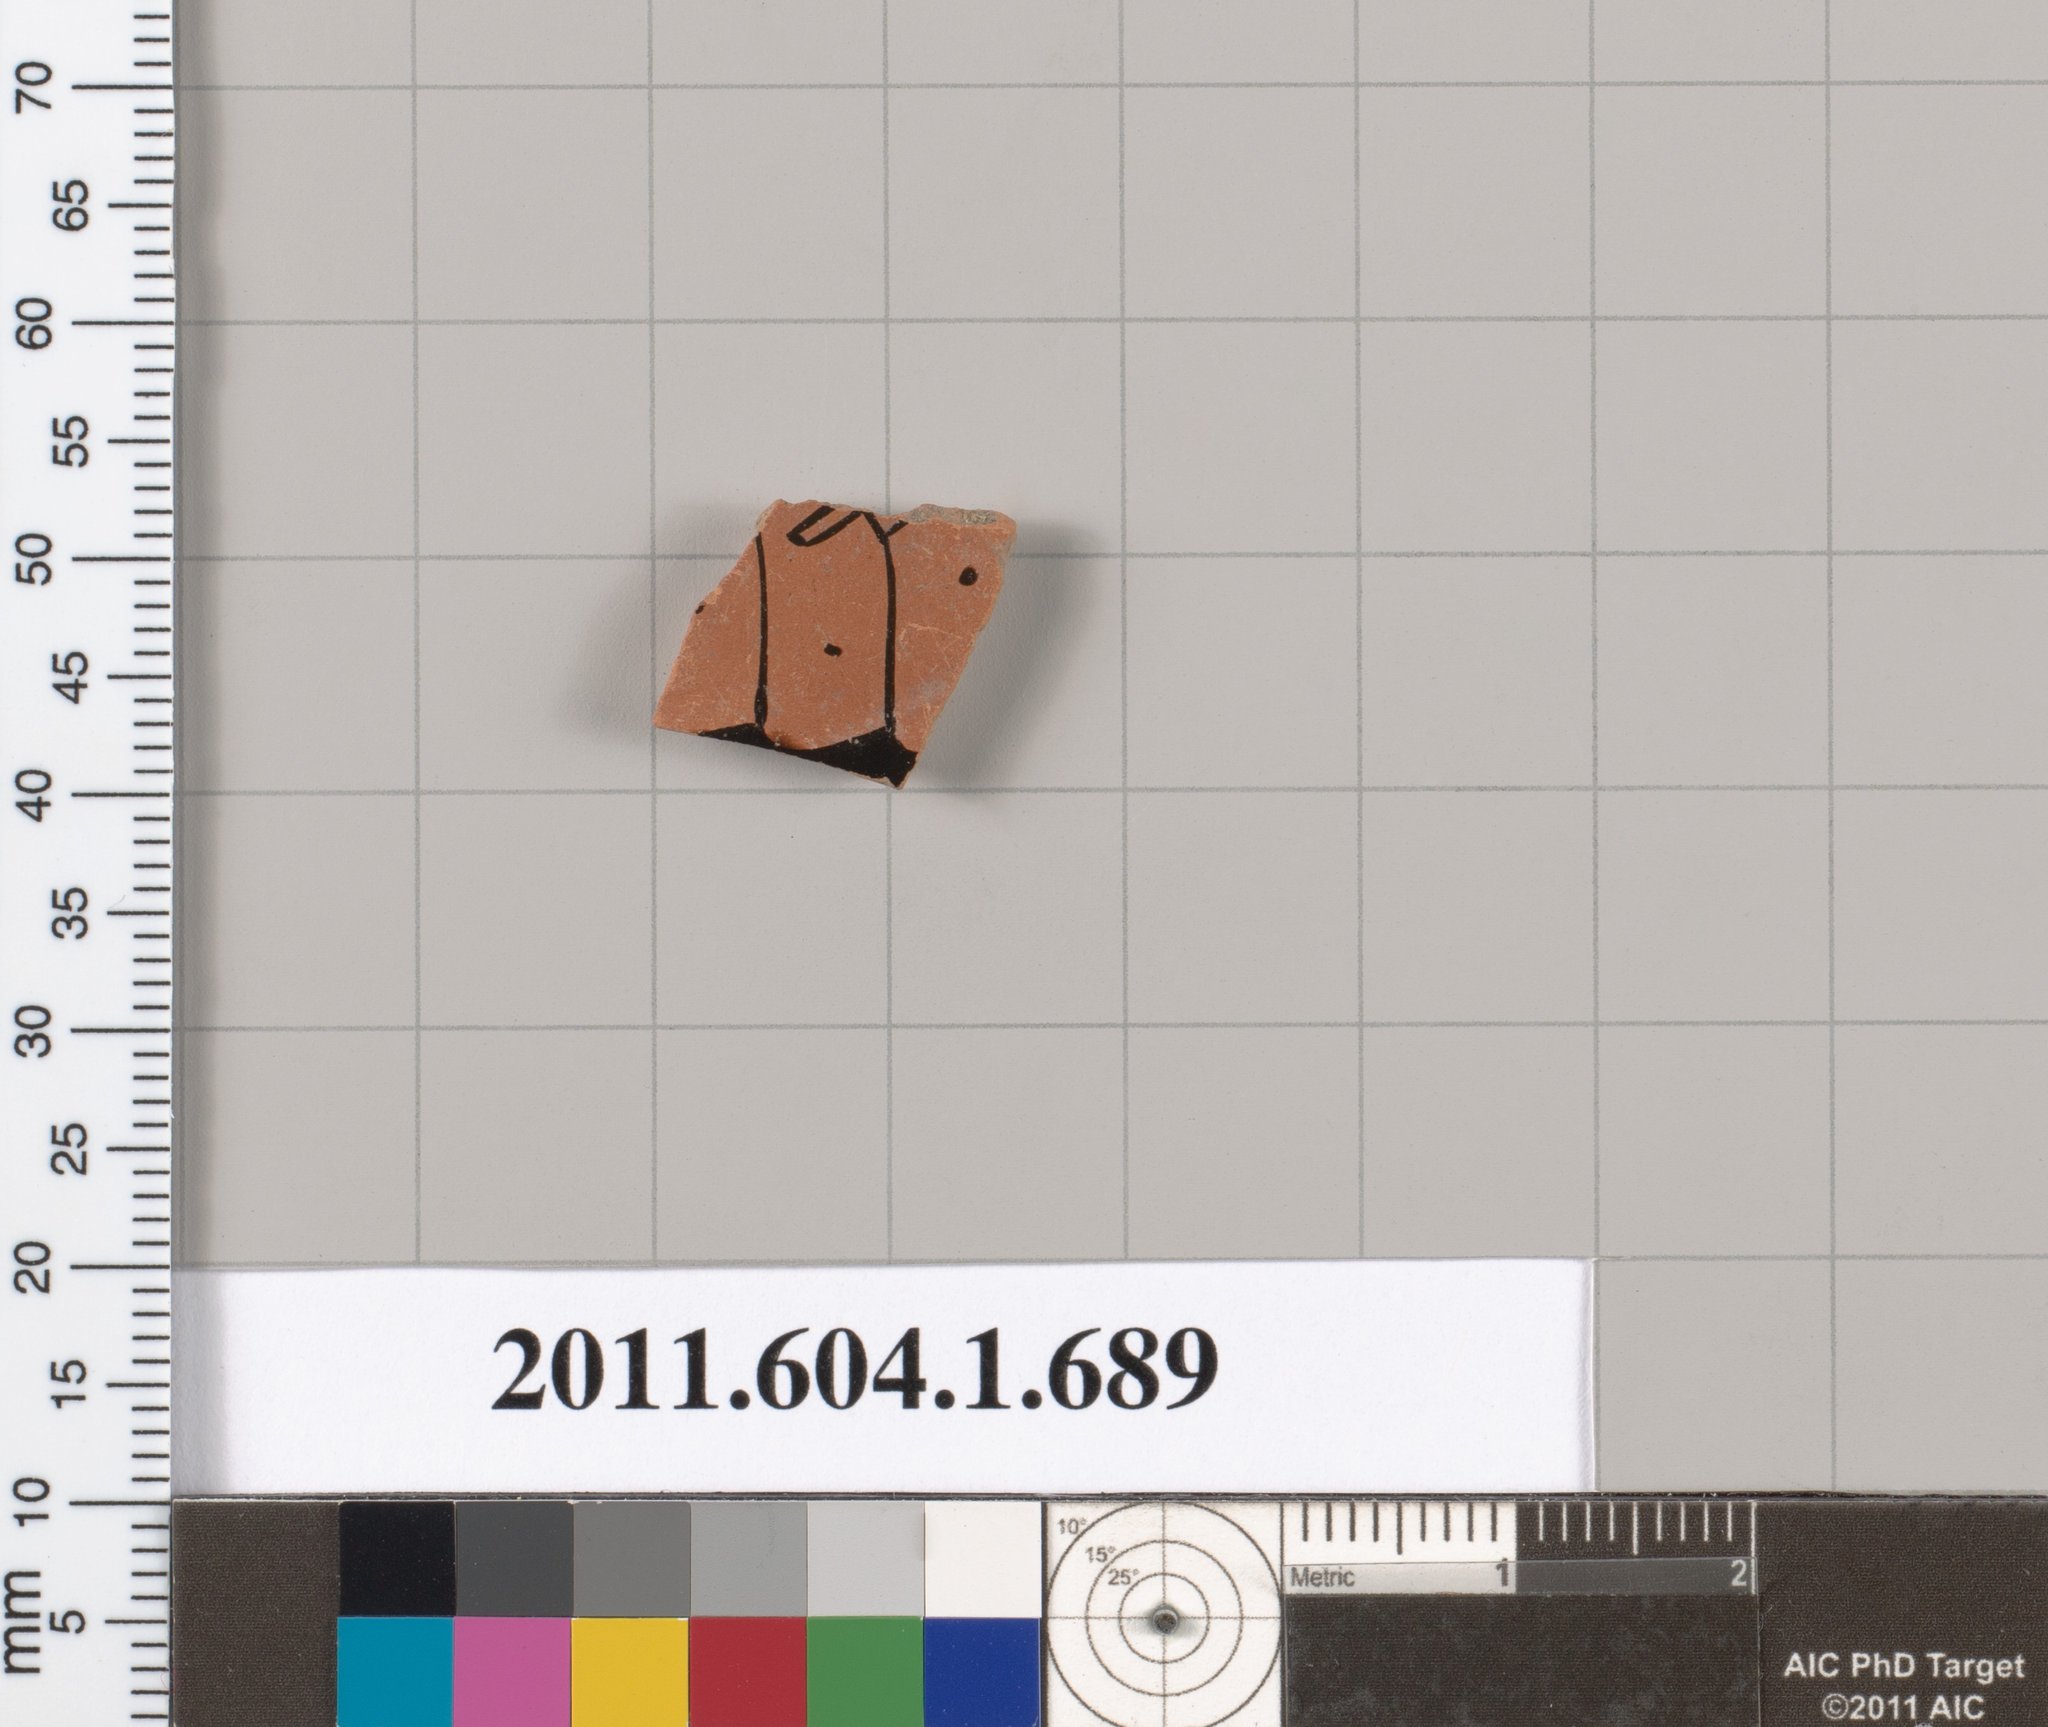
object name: kylix fragment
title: Terracotta fragment of a kylix (drinking cup)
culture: greek, attic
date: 490-480 BCE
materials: terracotta